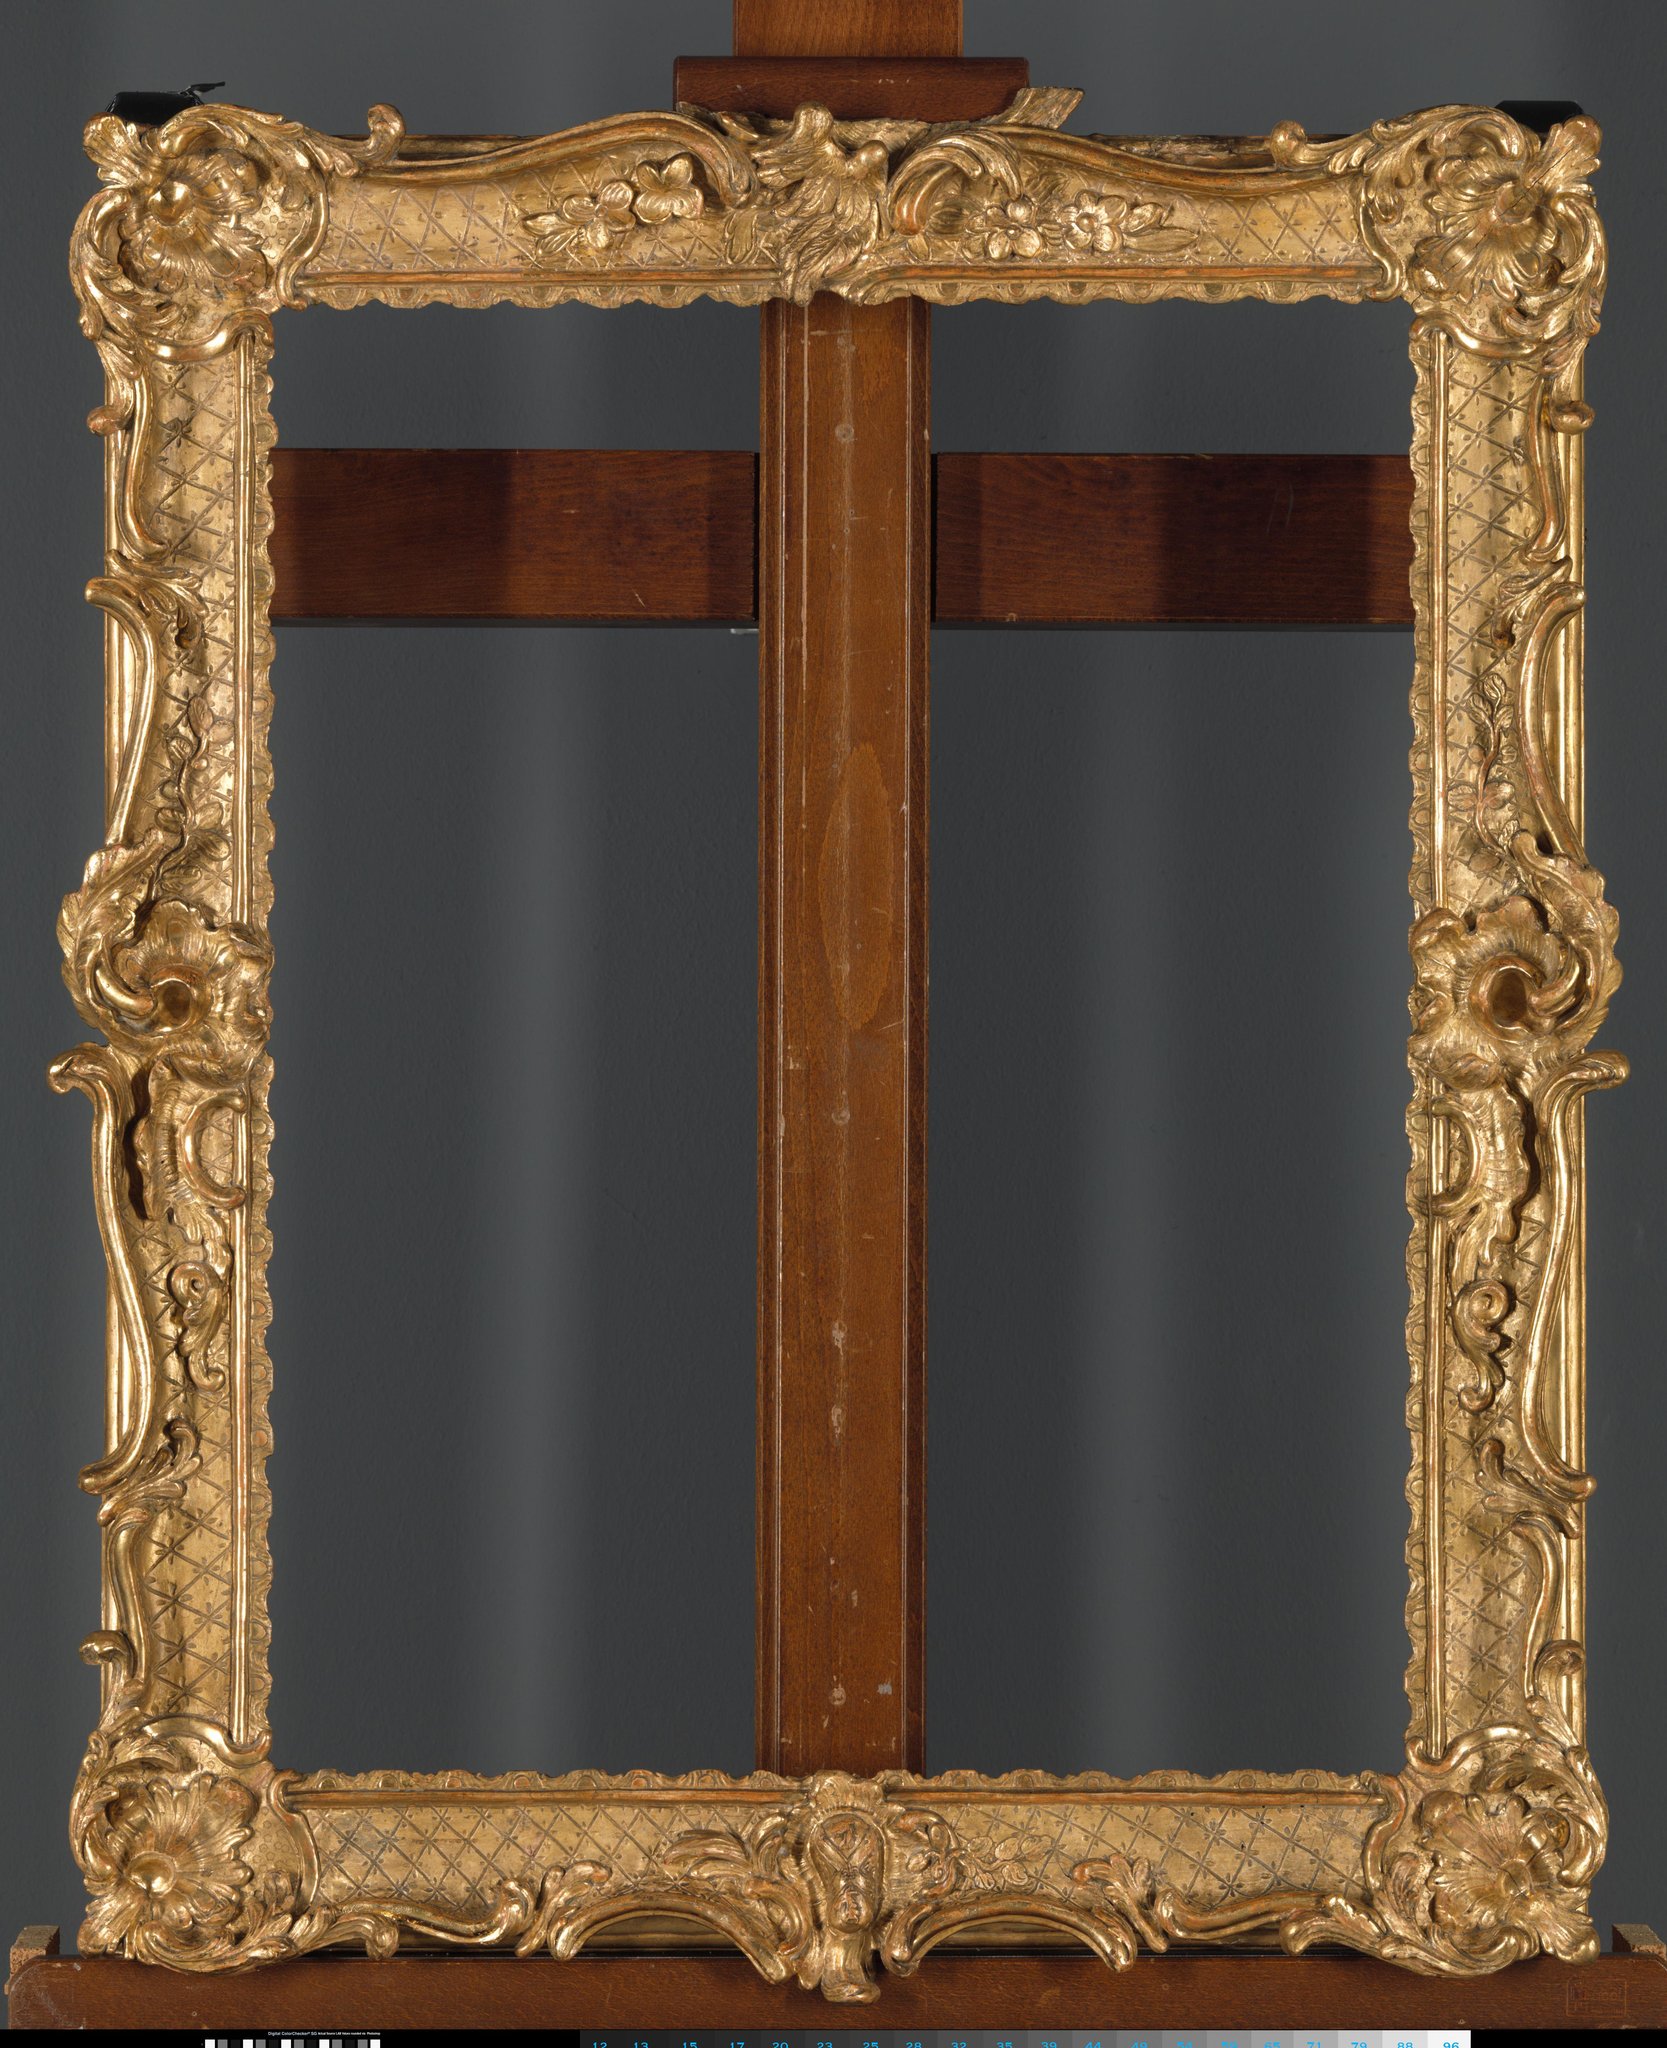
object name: frame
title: Gesneden en vergulde lijst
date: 1840-1850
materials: wood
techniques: cutting, gilding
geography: switzerland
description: Gesneden en vergulde lijst in Rococo-stijl. Decoratieve bekroning ontbreekt. De gedeeltelijk matte en gedeeltelijk glanzende vergulding is oorspronkelijk.